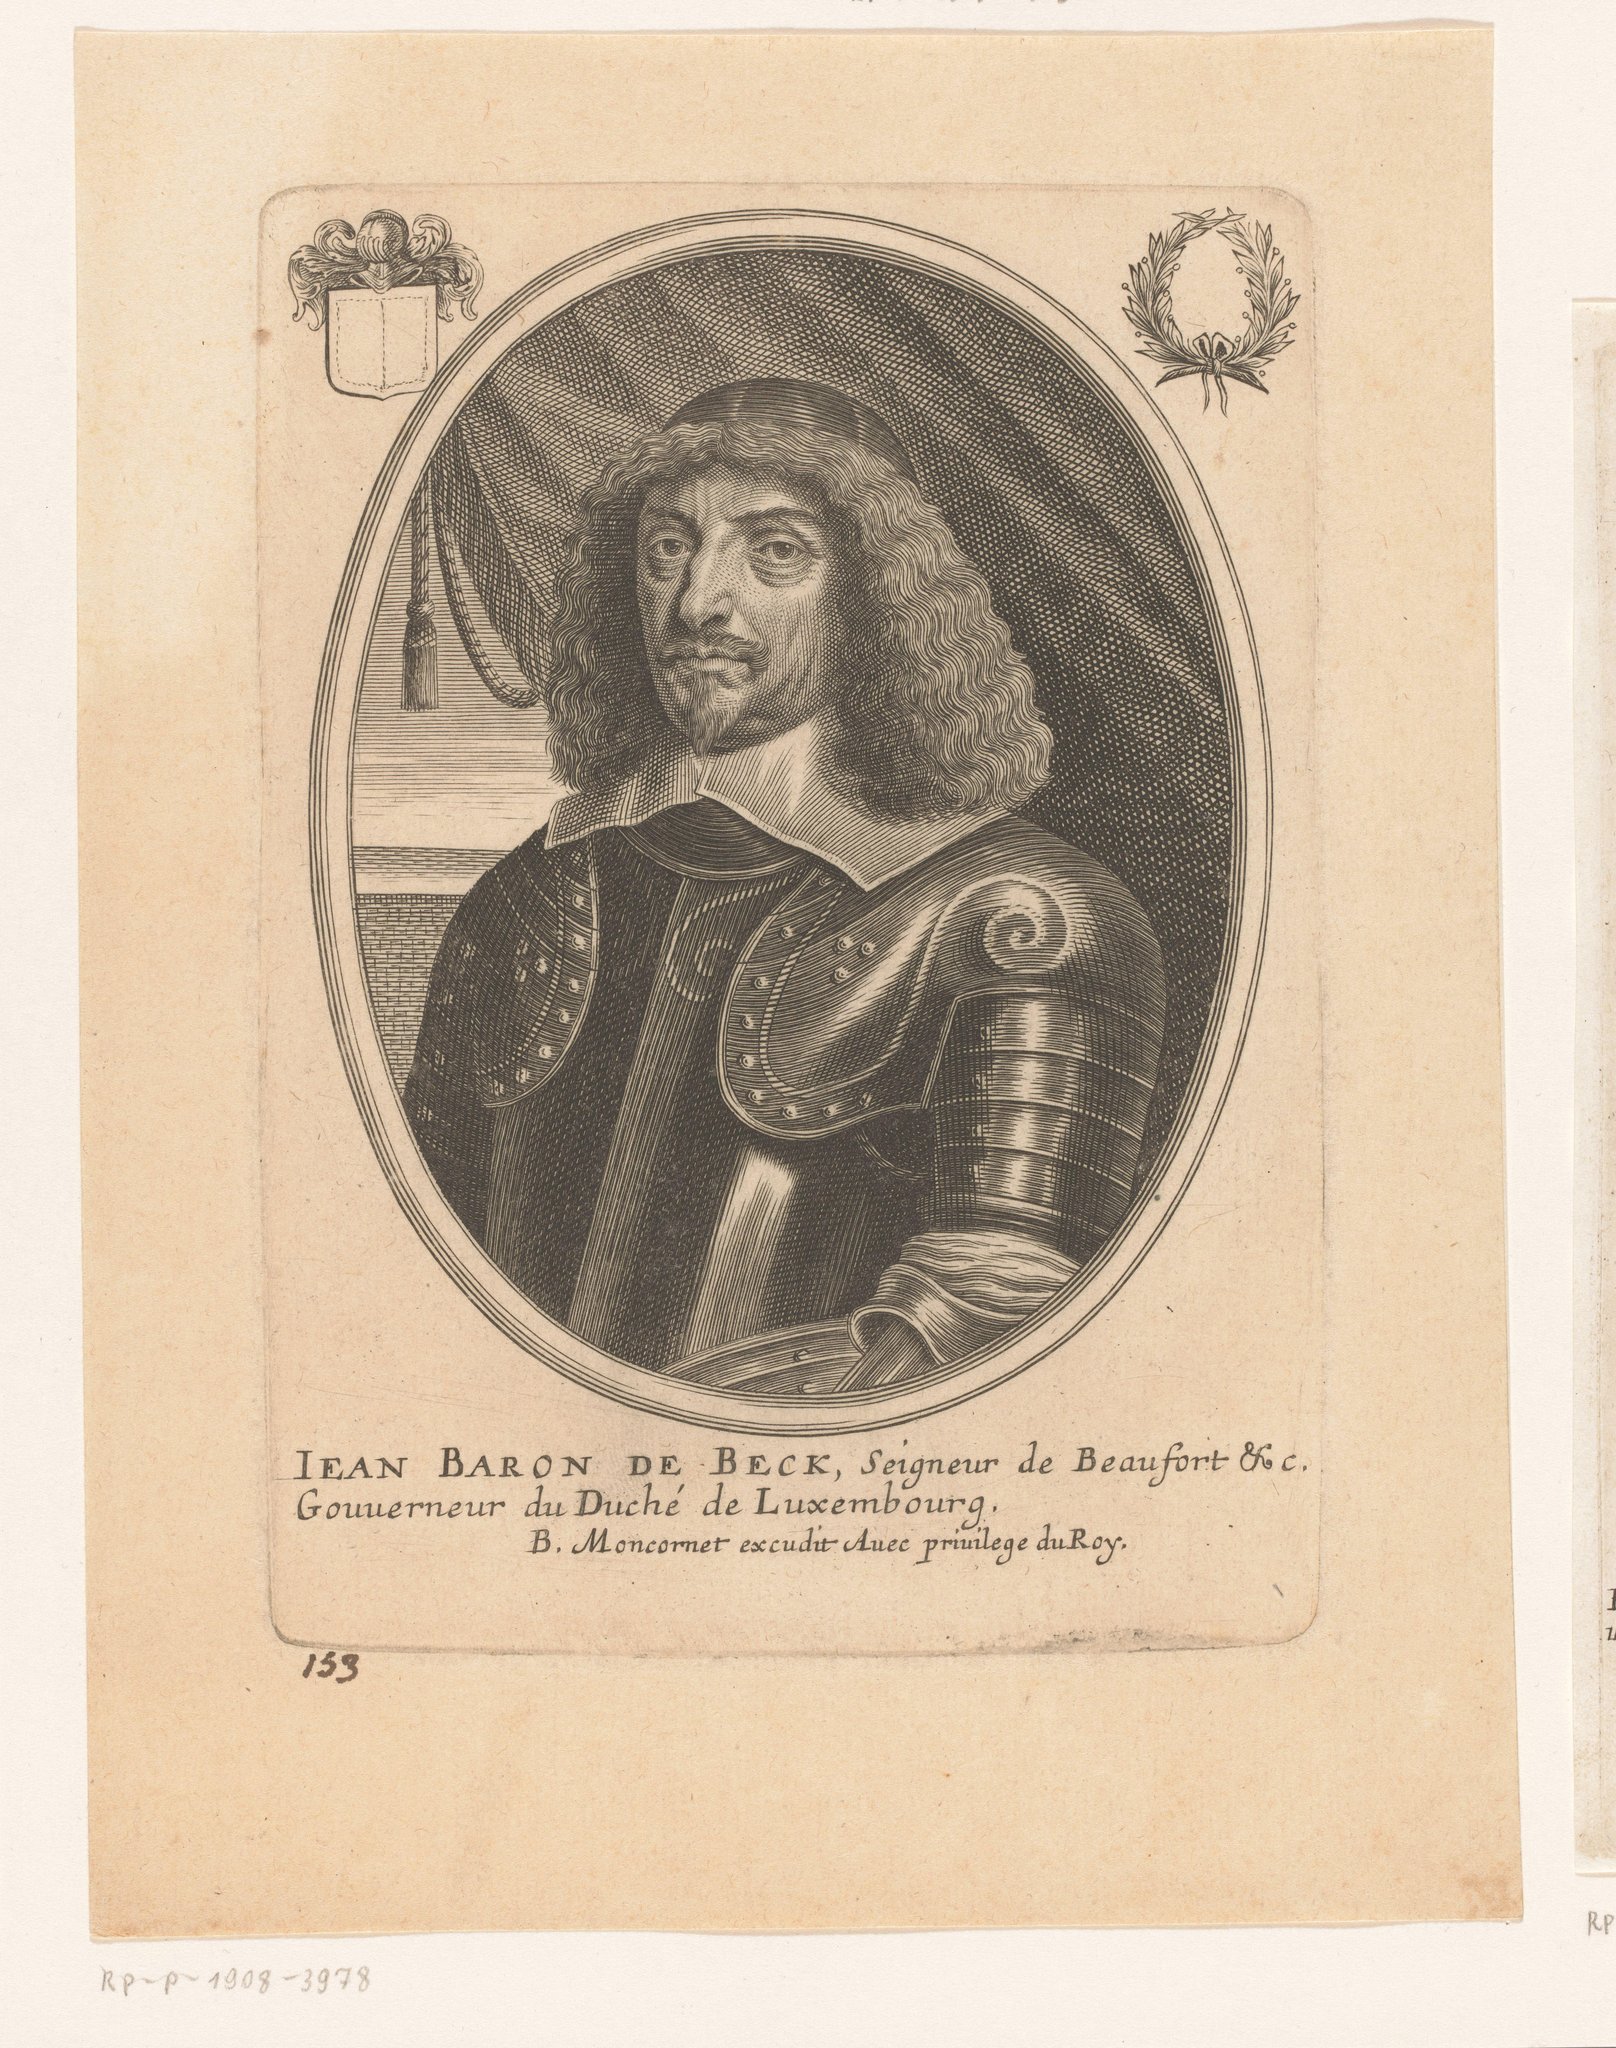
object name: print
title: Portret van Johan van Beck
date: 1610-1668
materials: paper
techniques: engraving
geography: paris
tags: historical persons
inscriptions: collector's mark: Lugt 2228